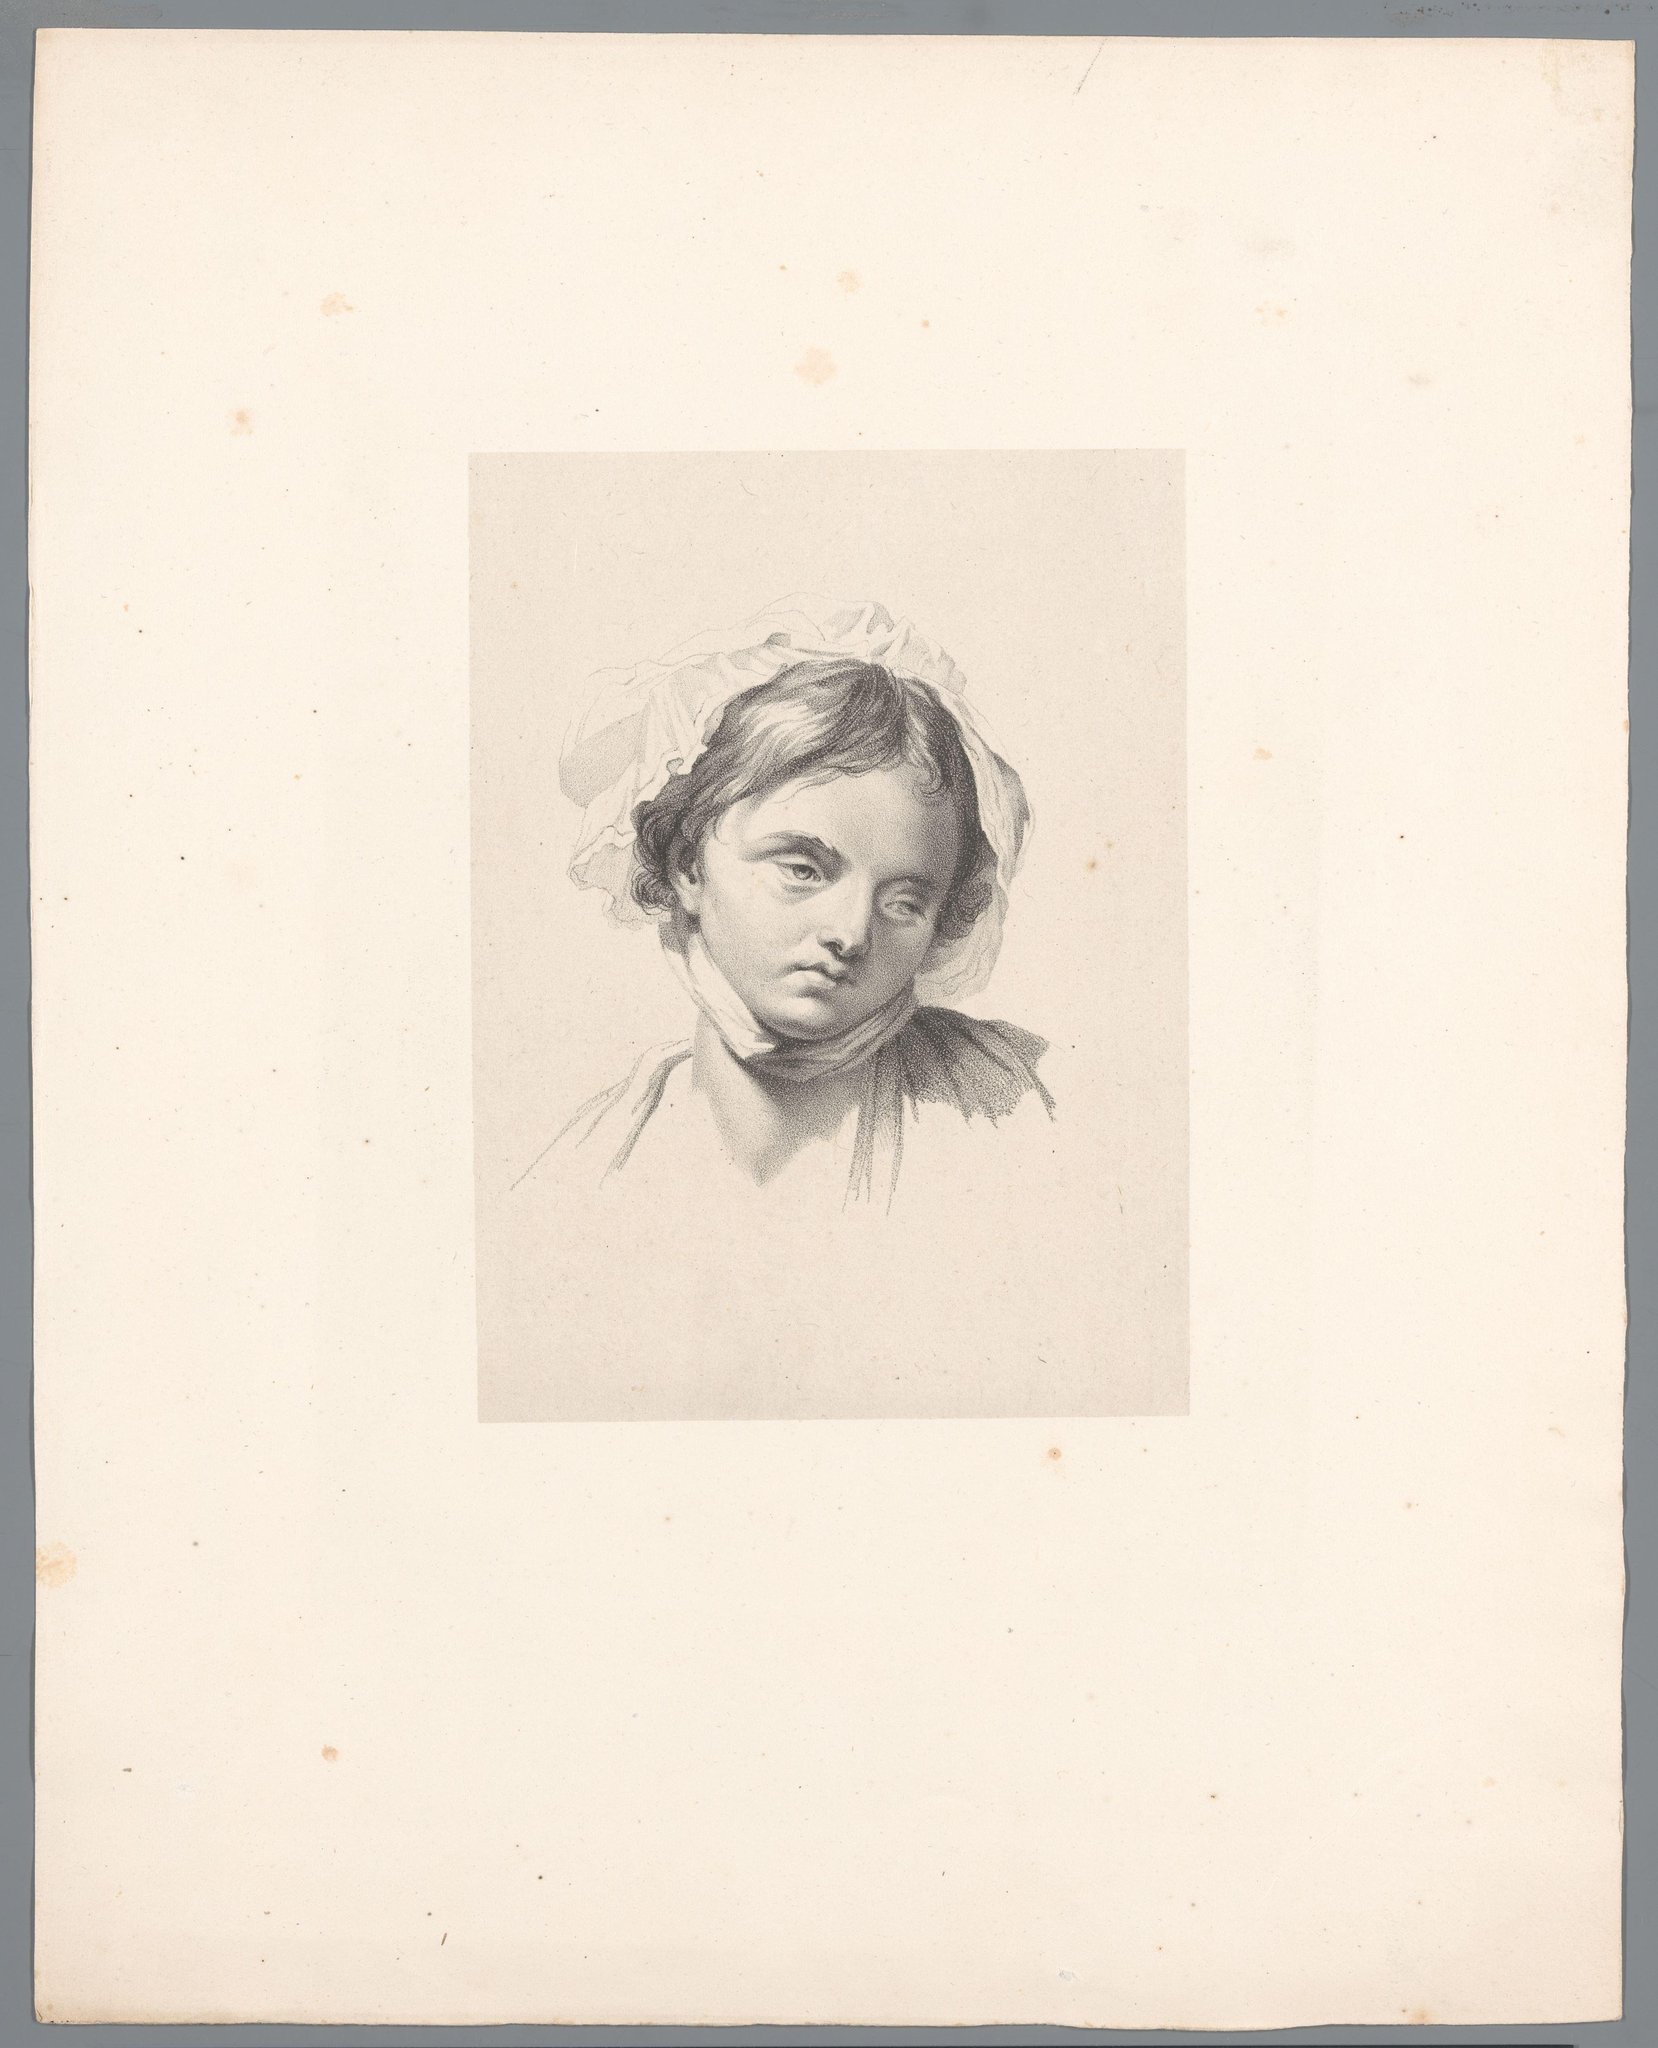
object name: print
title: Droevig meisje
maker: jean augustin daiwaille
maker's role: draughtsman, print maker, printer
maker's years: 1786-1850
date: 1820-1830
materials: paper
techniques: lithograph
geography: amsterdam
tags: adolescent, young woman, maiden, head-gear: cap, looking downwards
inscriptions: collector's mark: Lugt 2228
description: 'Hartstochten na J.B. Greuze' bestaat uit twee of drie genummerde reeksen. (Sommige nummers komen drie keer voor op drie verschillende afbeeldingen.) Binnen deze omslag bevinden zich achttien verschillende afbeeldingen. Mogelijk heeft dit te maken met de twee momenten waarop Daiwaille de reeks uitgaf, ten tijden van zijn directeurschap aan de Rijksakademie in Amsterdam en daarna als zelfstandige. De omslag behoort waarschijnlijk bij een van deze twee series. Zie Marres-Schretlen in het Bulletin van het Rijksmuseum.